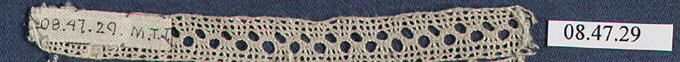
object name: fragment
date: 1801-1900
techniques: lace